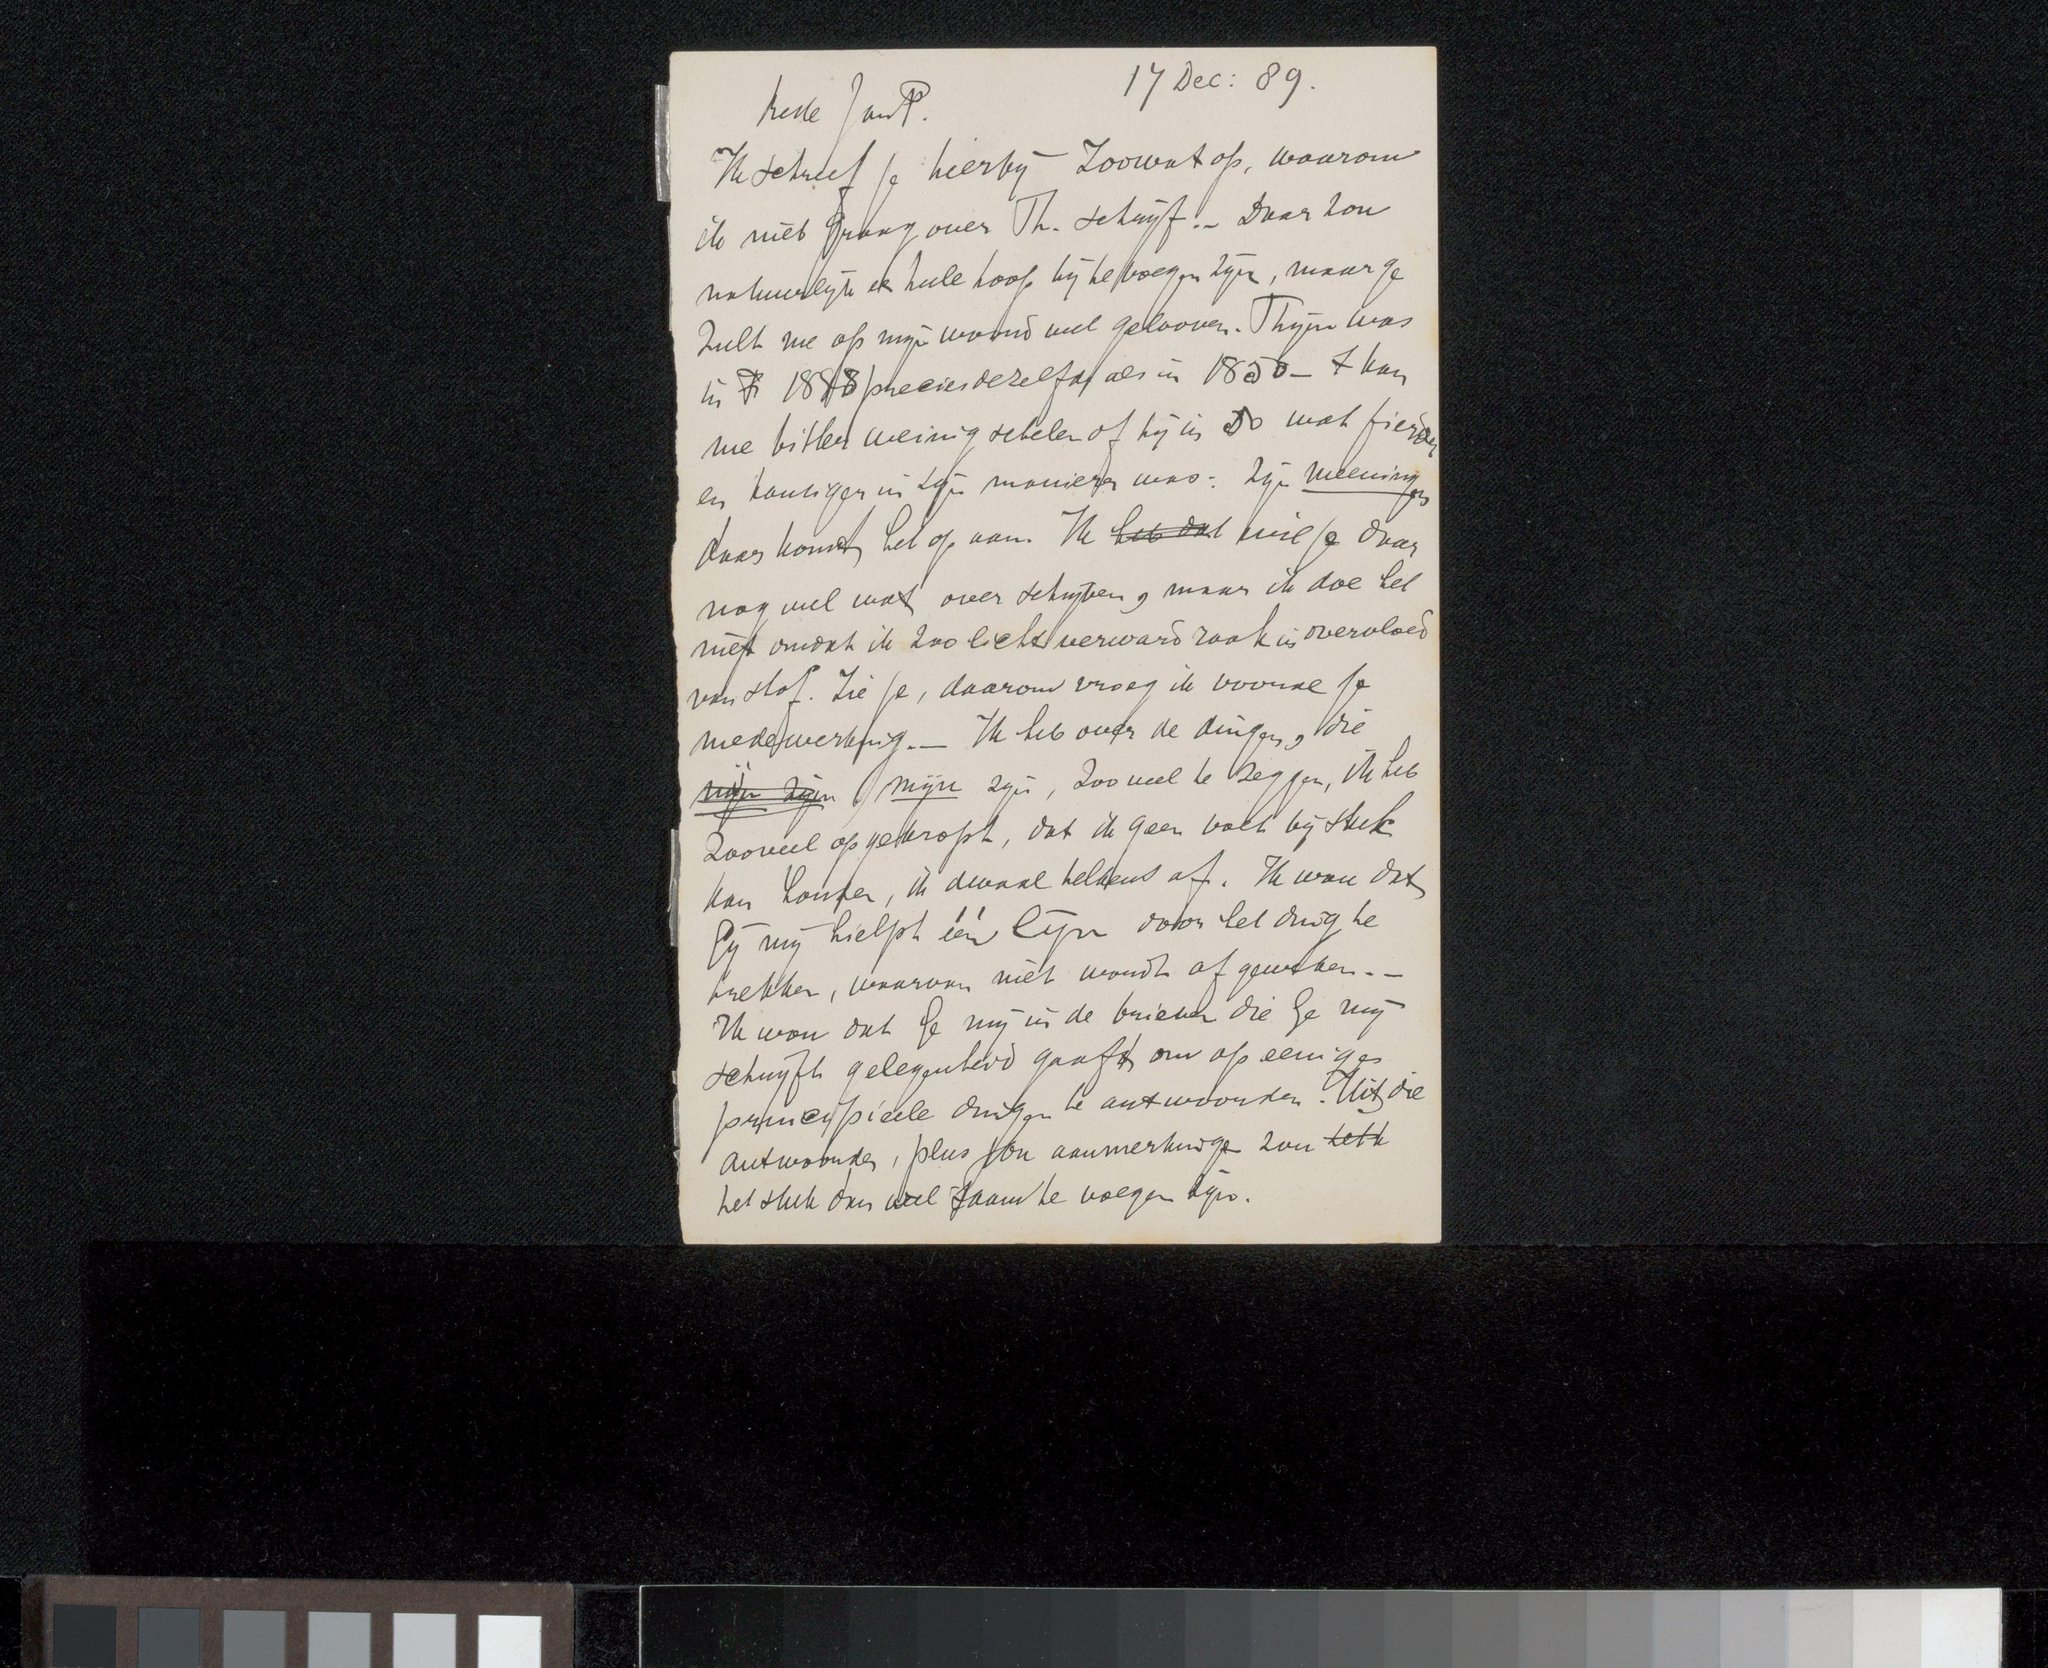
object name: letter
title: Brief aan Jan Veth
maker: antoon derkinderen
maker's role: draughtsman, painter, print maker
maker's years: 1859-1925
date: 1874-1925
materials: ink, paper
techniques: pen, writing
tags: dordrecht, amsterdam, painter, print maker, draughtsman, designer, jan veth, publisher, josephus albertus alberdingk thijm, printed matter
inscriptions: collector's mark: ‘RPK’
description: Brief gedateerd 17 Dec: 89 in latere hand.